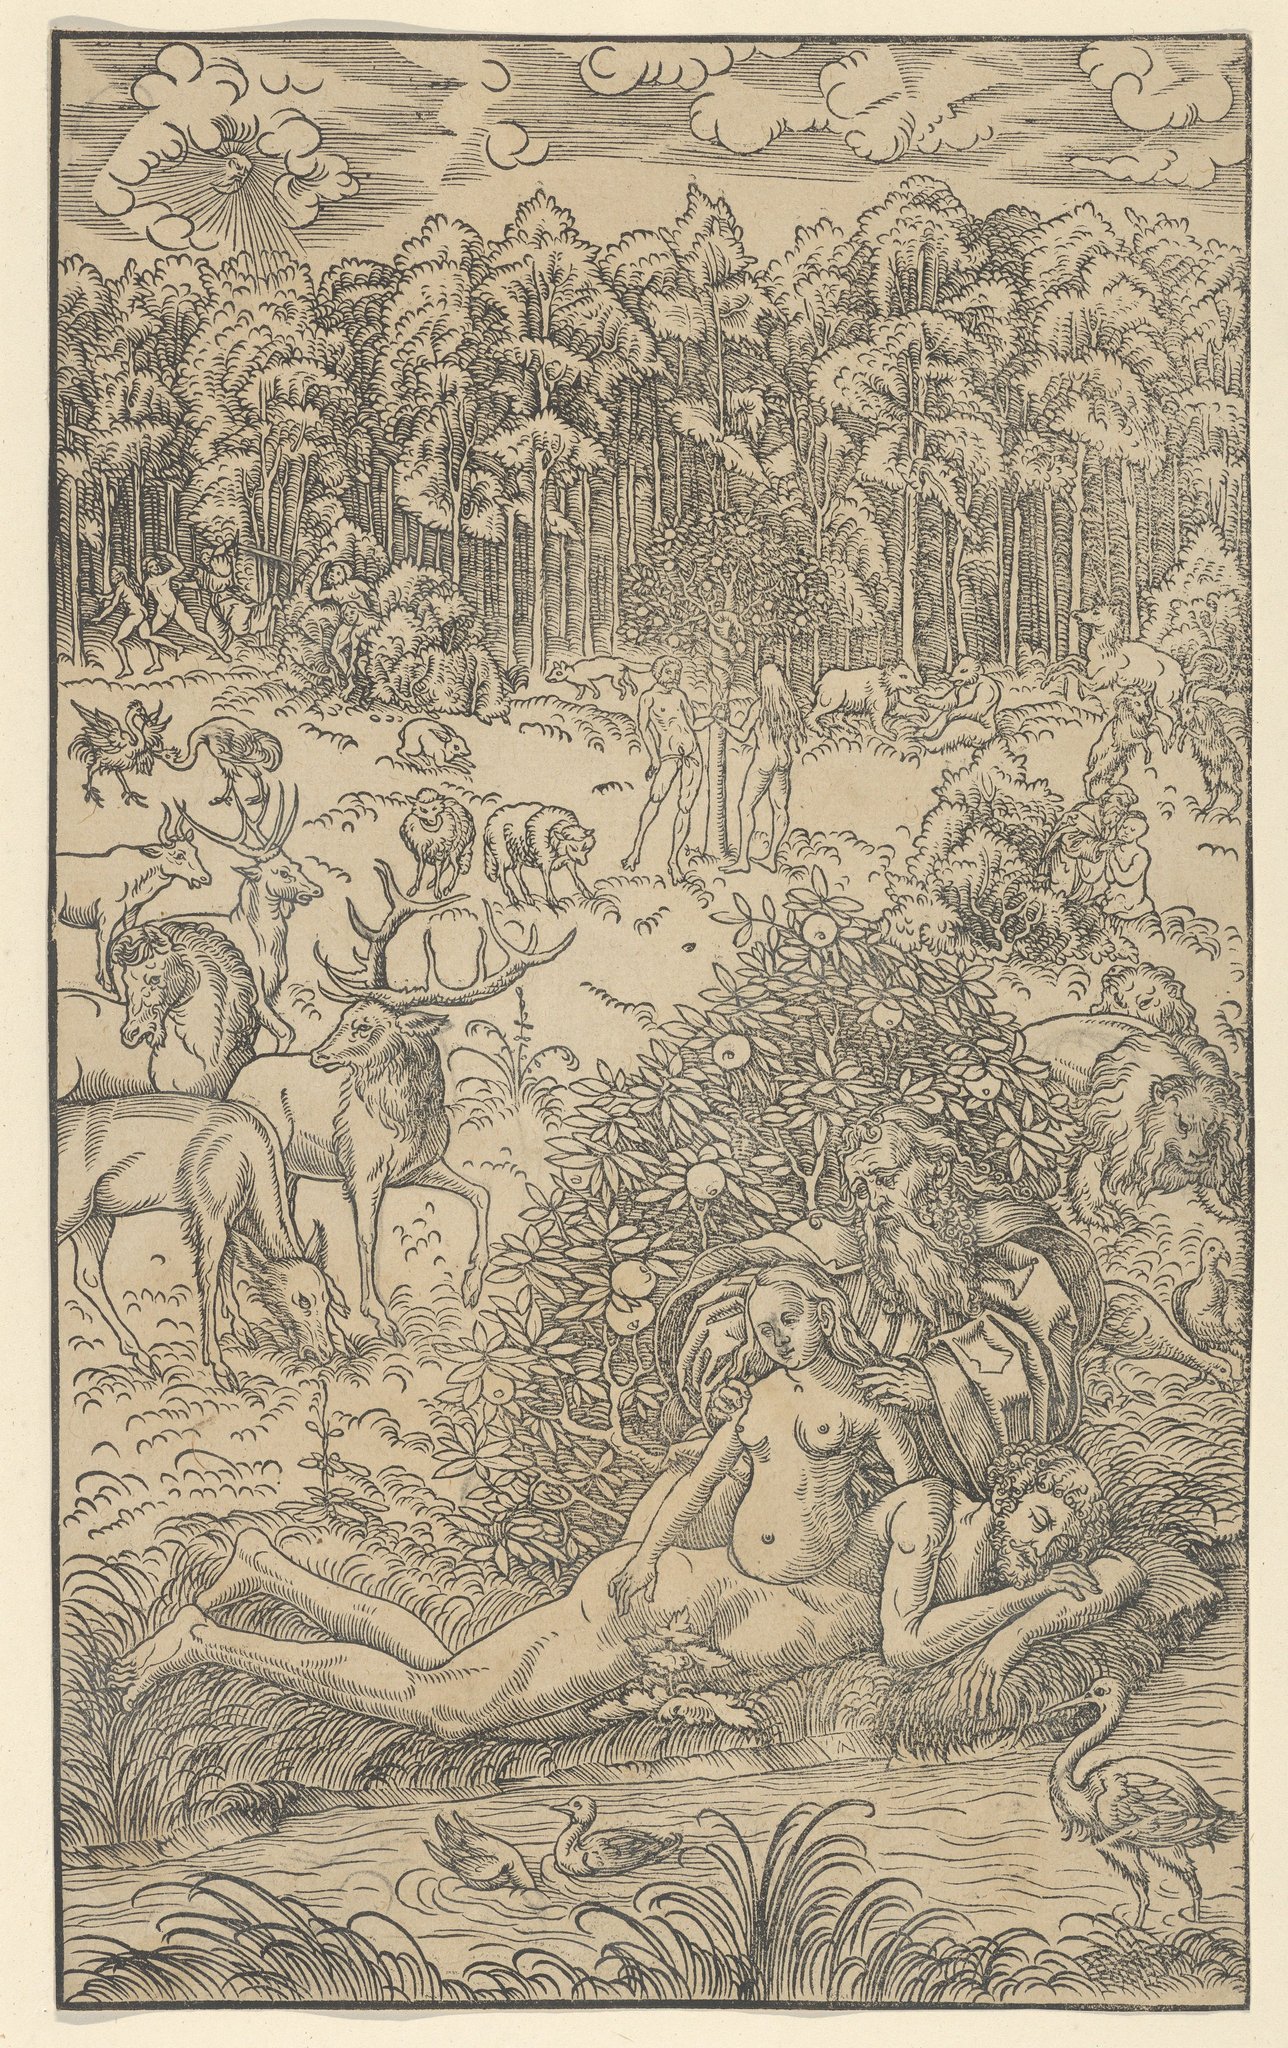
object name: print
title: The Creation of Eve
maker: lucas cranach the younger and workshop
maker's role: artist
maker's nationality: german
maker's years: 1515-1586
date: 1515-1586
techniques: woodcut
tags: birds,deer,lions,sheep,adam,eve